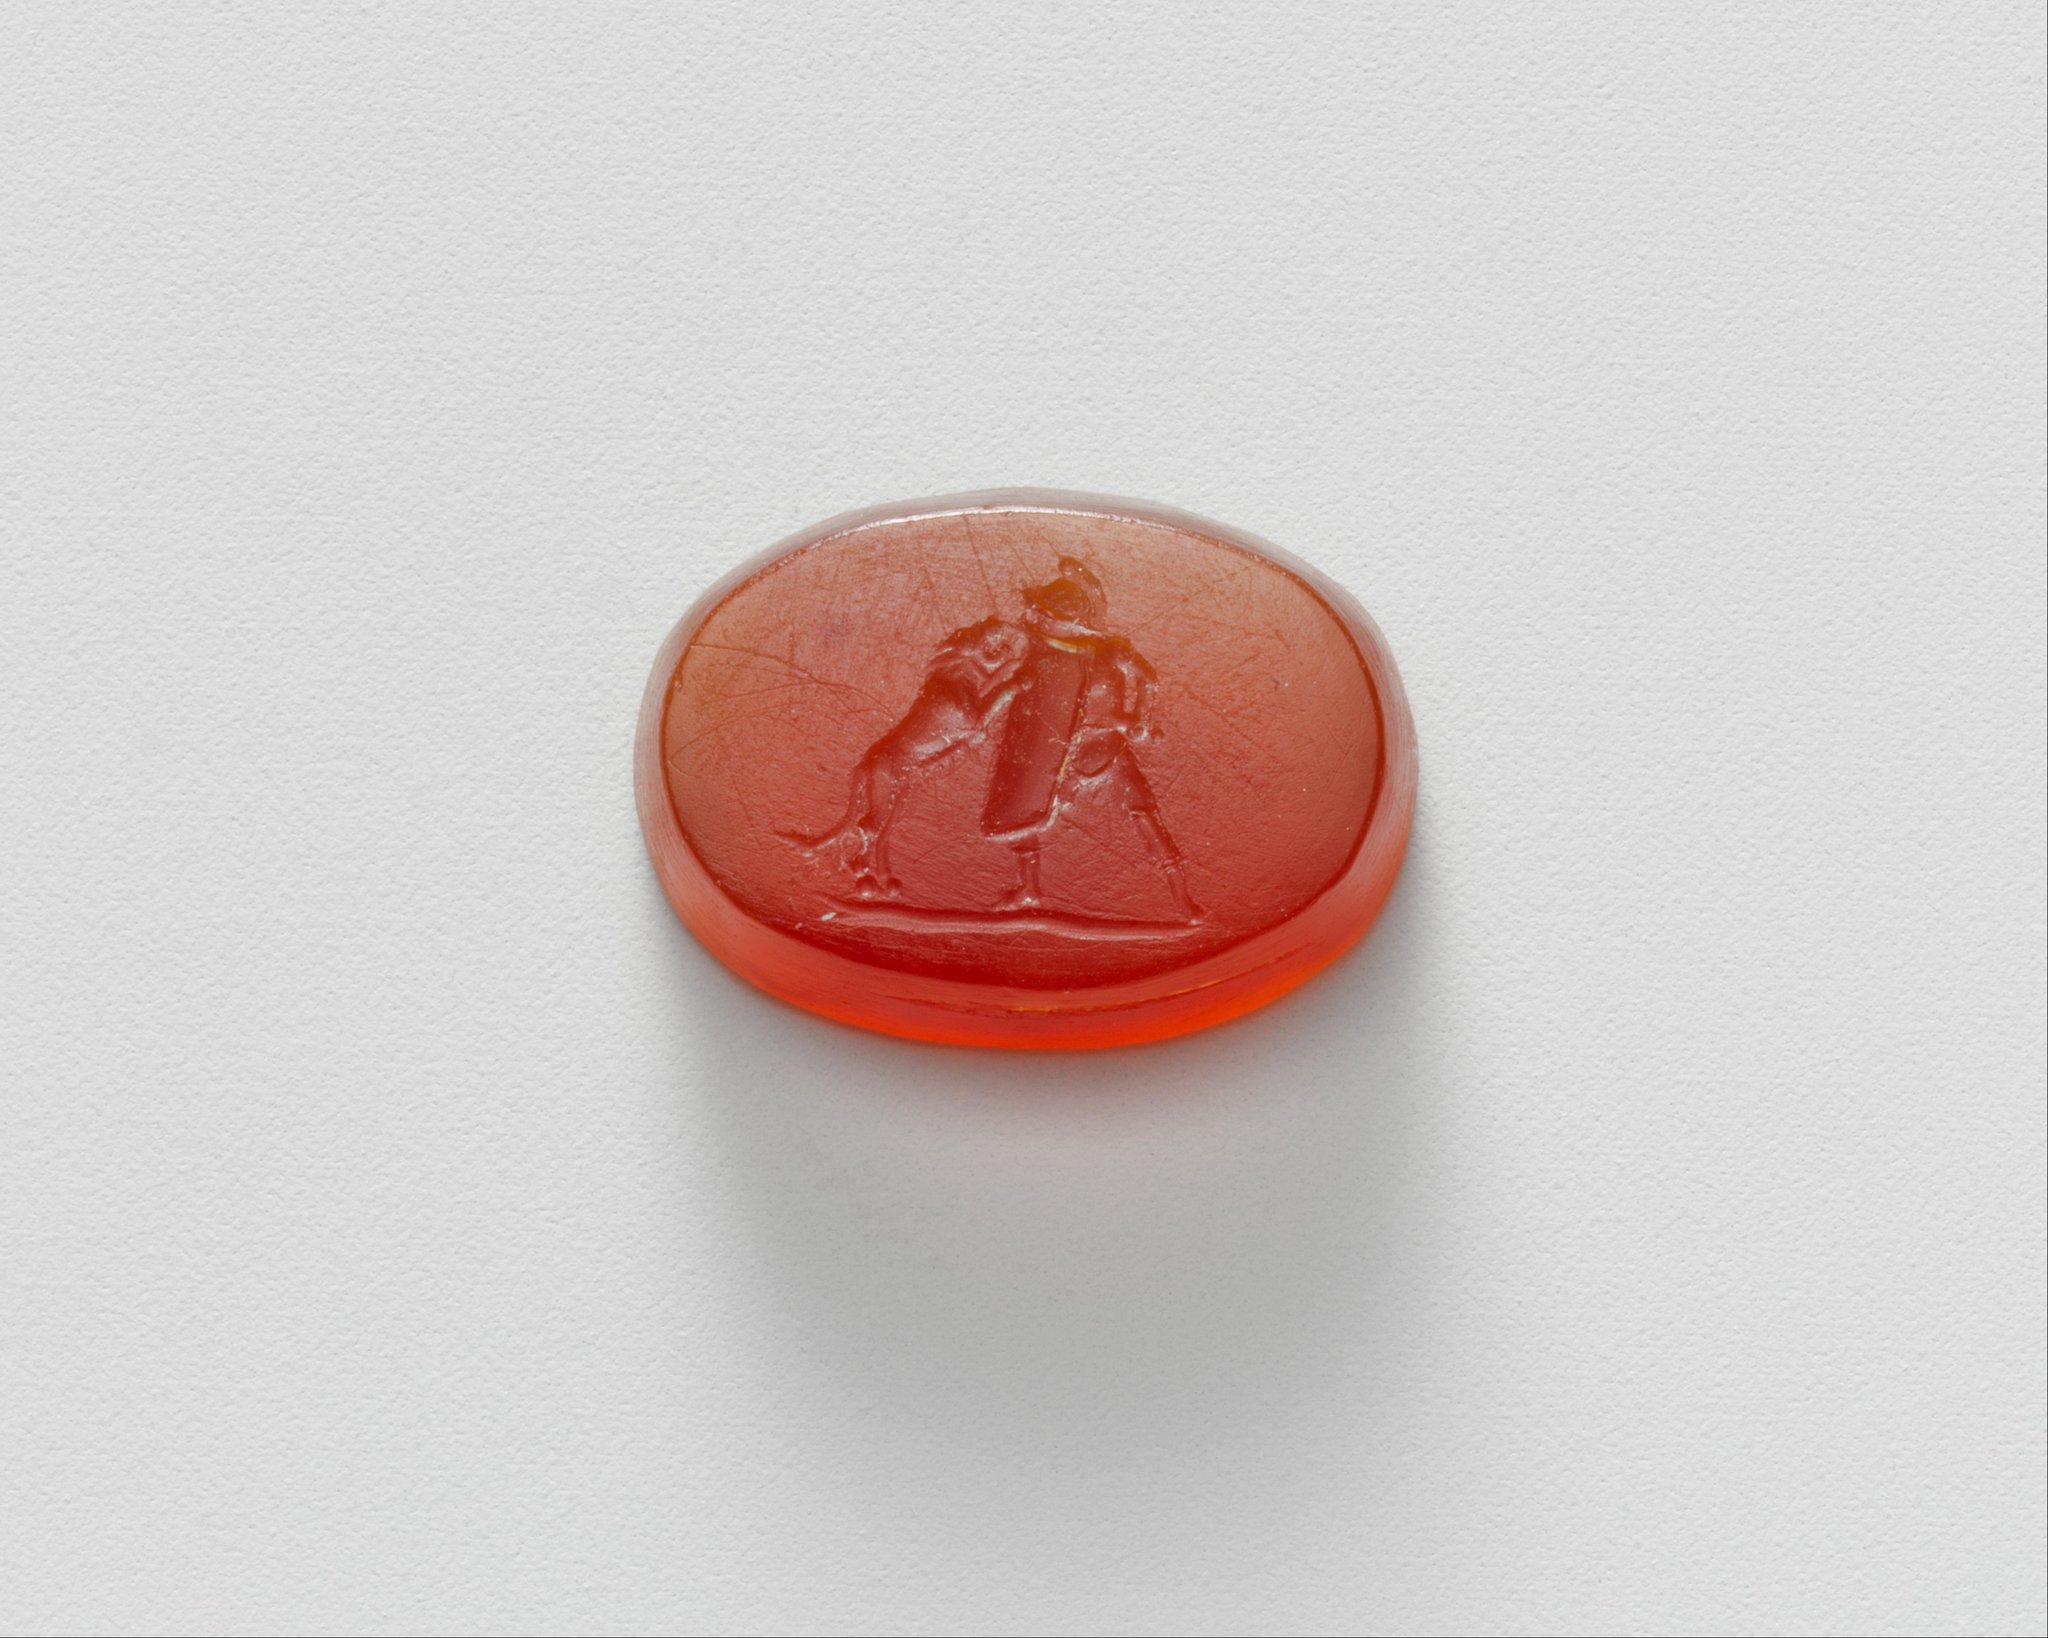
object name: intaglio, gladiator battling a lion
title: Carnelian intaglio of a gladiator fighting a lion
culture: roman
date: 1-50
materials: gemstone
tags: shields,men,lions